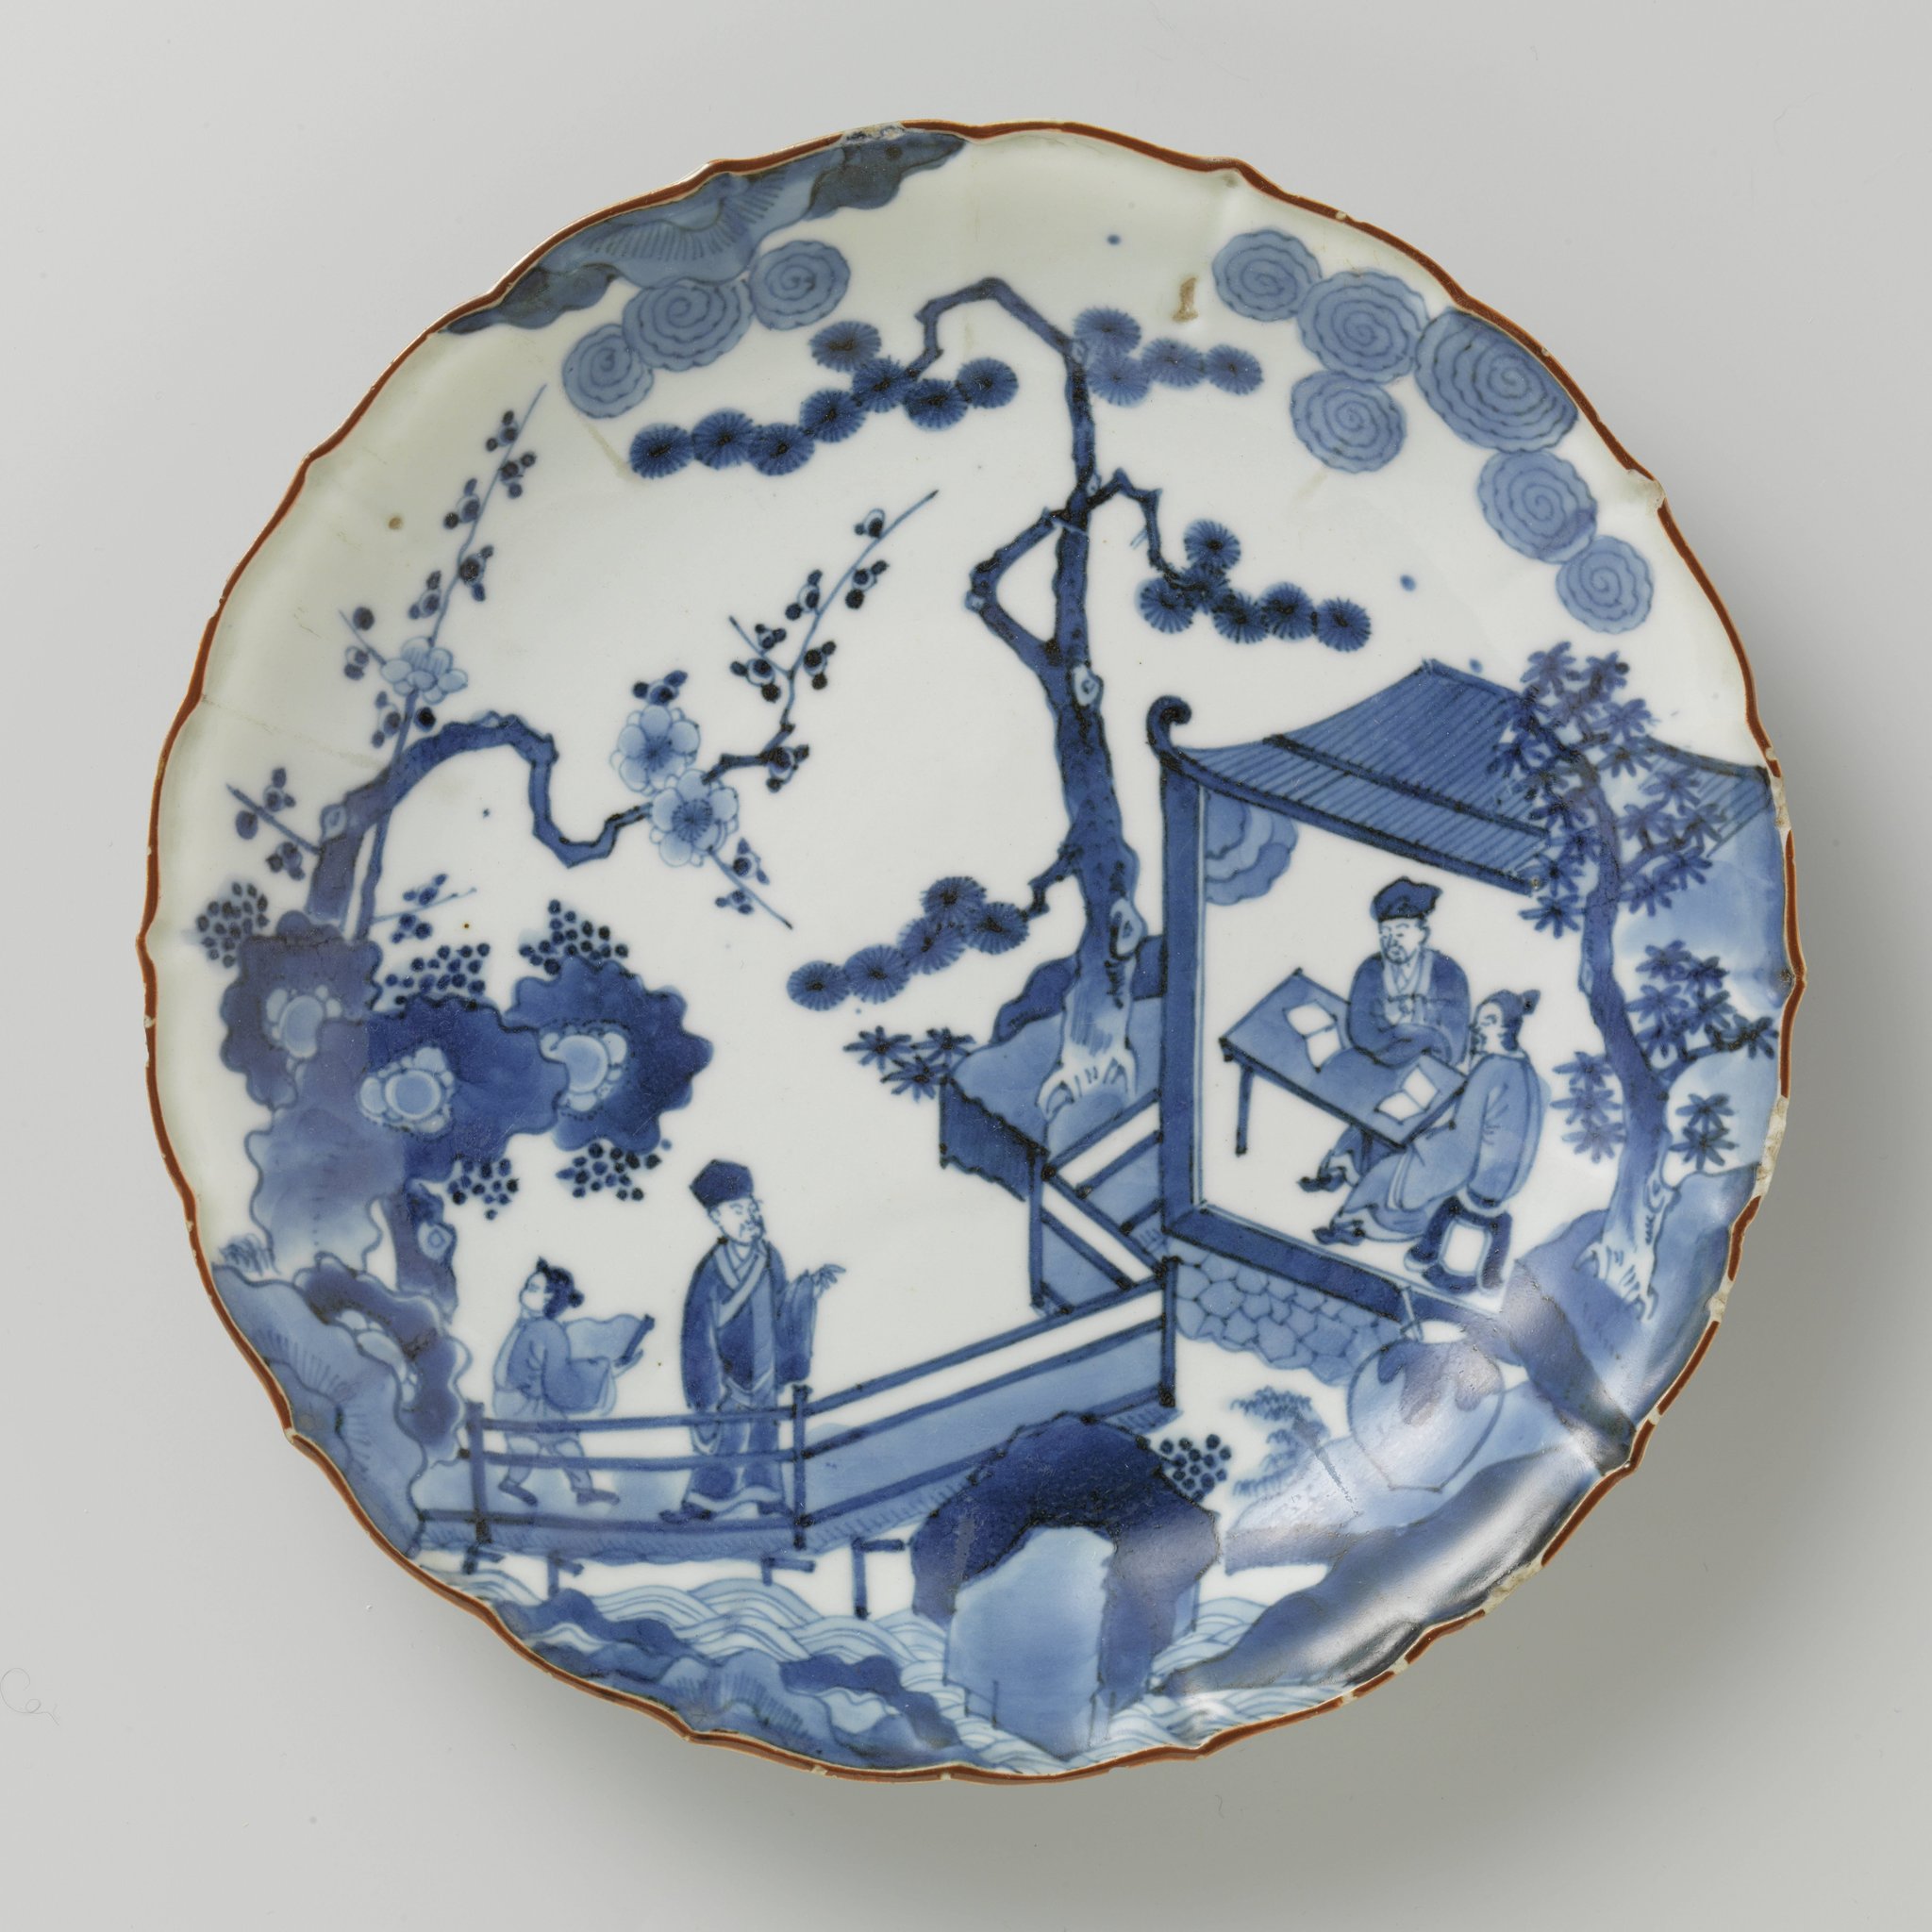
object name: plate dish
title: Saucer-dish with figures in a pavilion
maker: Anonymous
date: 1670-1690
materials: cobalt, glaze, paint, porcelain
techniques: firing, turning, vitrification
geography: japan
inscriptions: mark: ‘Fuku’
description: Schaal van porselein met accoladevormige rand, beschilderd in onderglazuur blauw. De voorzijde van de schotel met een rivierlandschap met twee Chinese mannen in een paviljoen. Een derde man met een bediende komt aanlopen over een brug. Rond het paviljoen bloeiende bomen (prunus, pijnboom), rotsen, een vaas en spiraalwolken. De buitenwand met een doorlopende bloemrank. Gemerkt op de onderzijde met 'fuku' in een dubbel vierkant en een cirkel. Zes proenen op de onderzijde. Enkele chips in de rand. Arita, Kakiemon in blauw-wit.